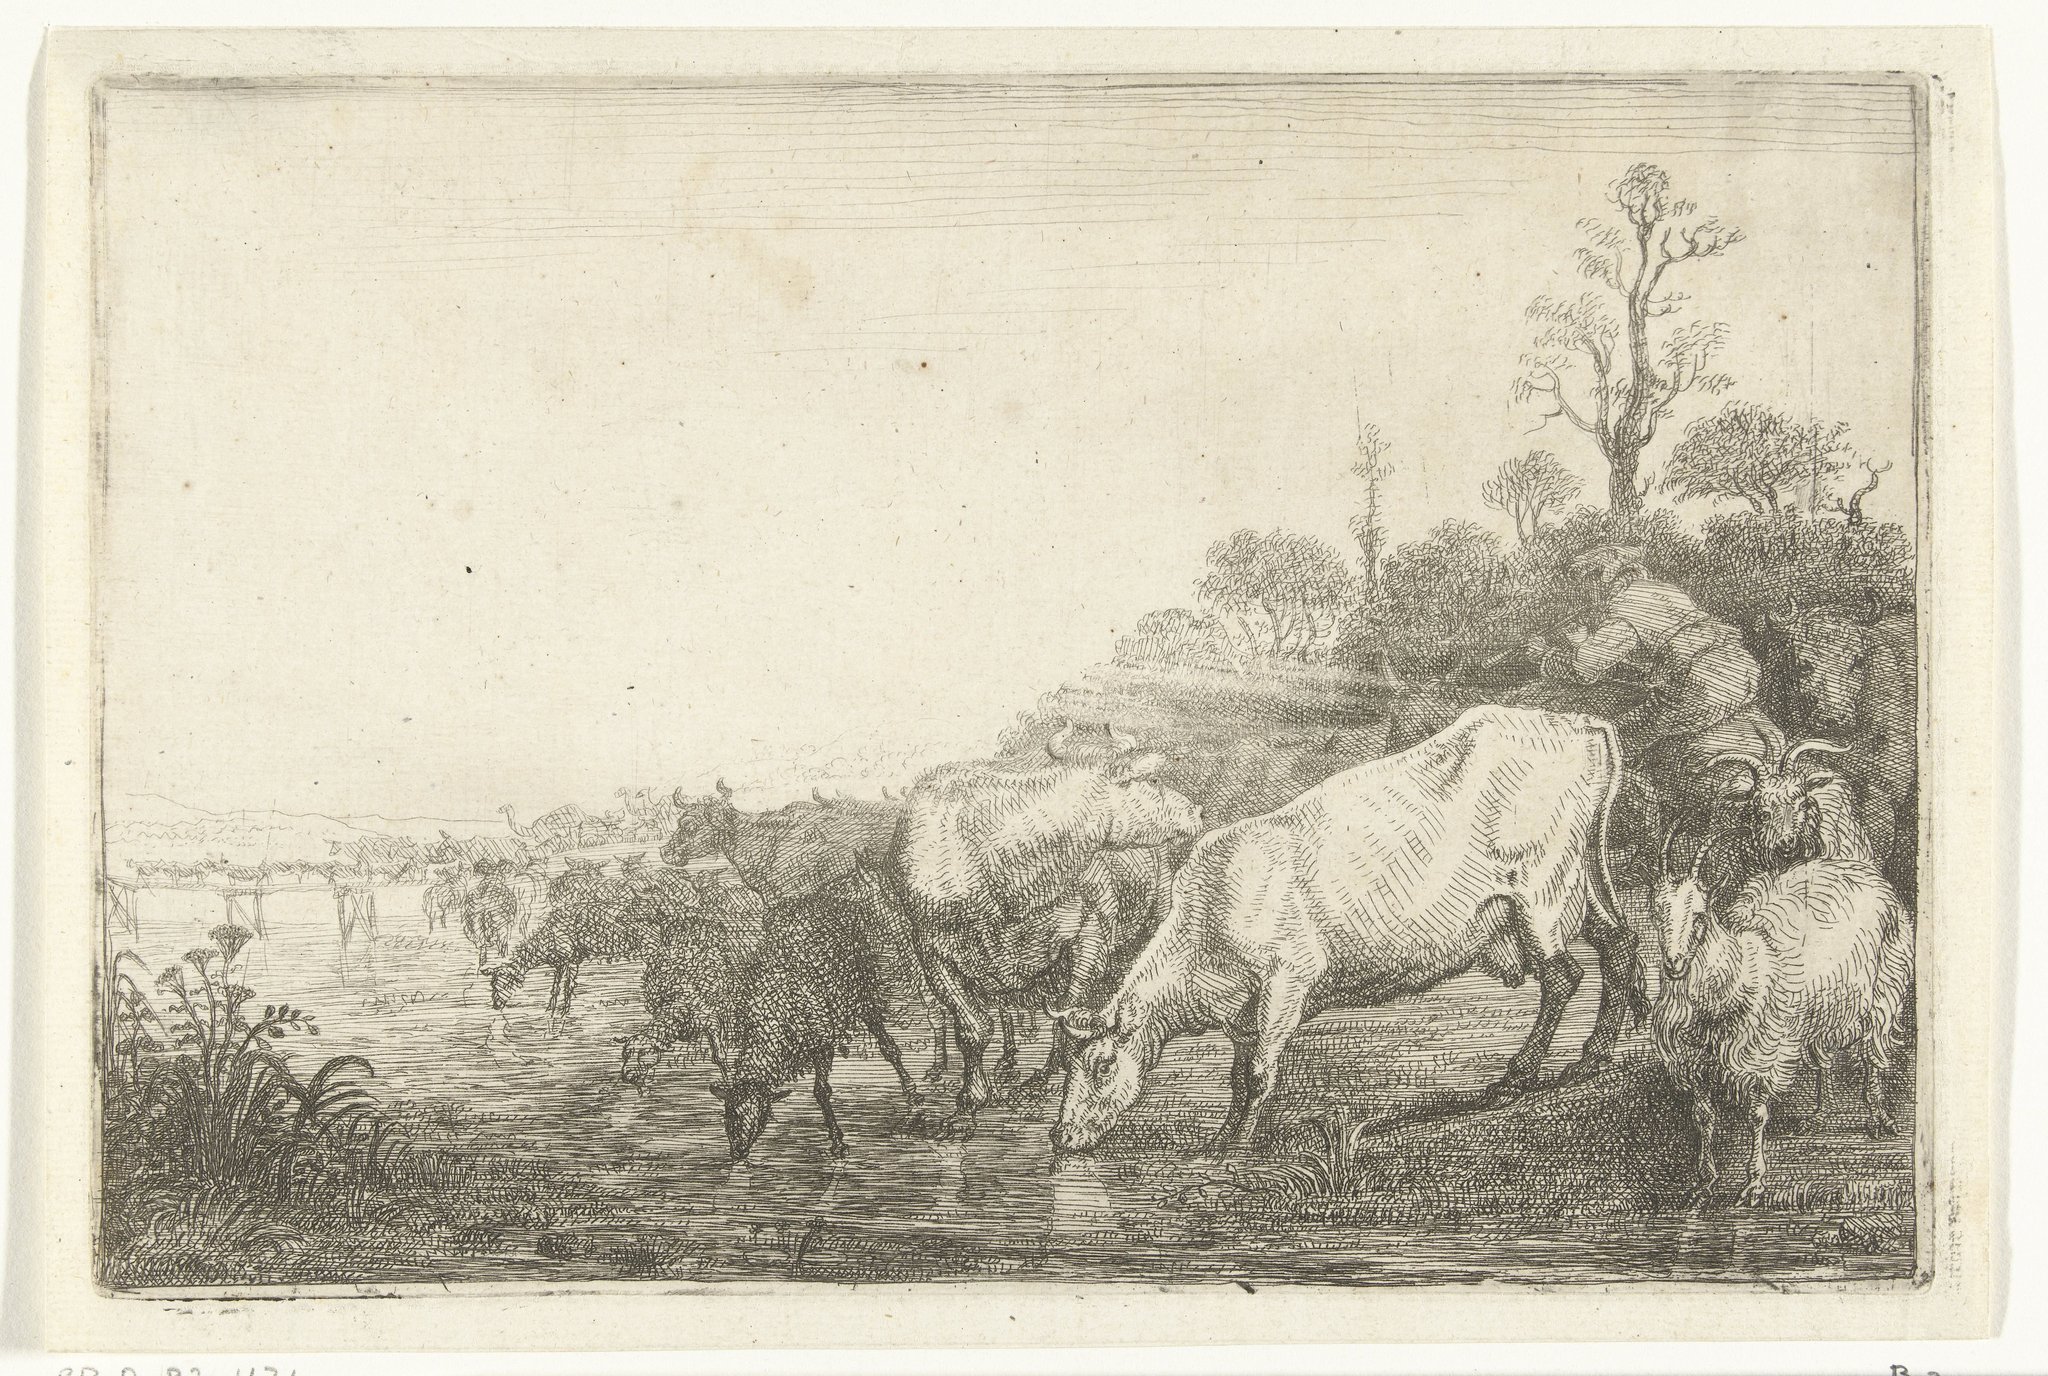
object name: print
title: Kudde bij een beek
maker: gerrit bleker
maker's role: print maker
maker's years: -1656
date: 1638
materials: paper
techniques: etching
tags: cattle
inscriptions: collector's mark: Lugt 240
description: Een kudde koeien, schapen en geiten drinkt bij een beek. De koeherder zit op een koe en speelt op zijn fluit.